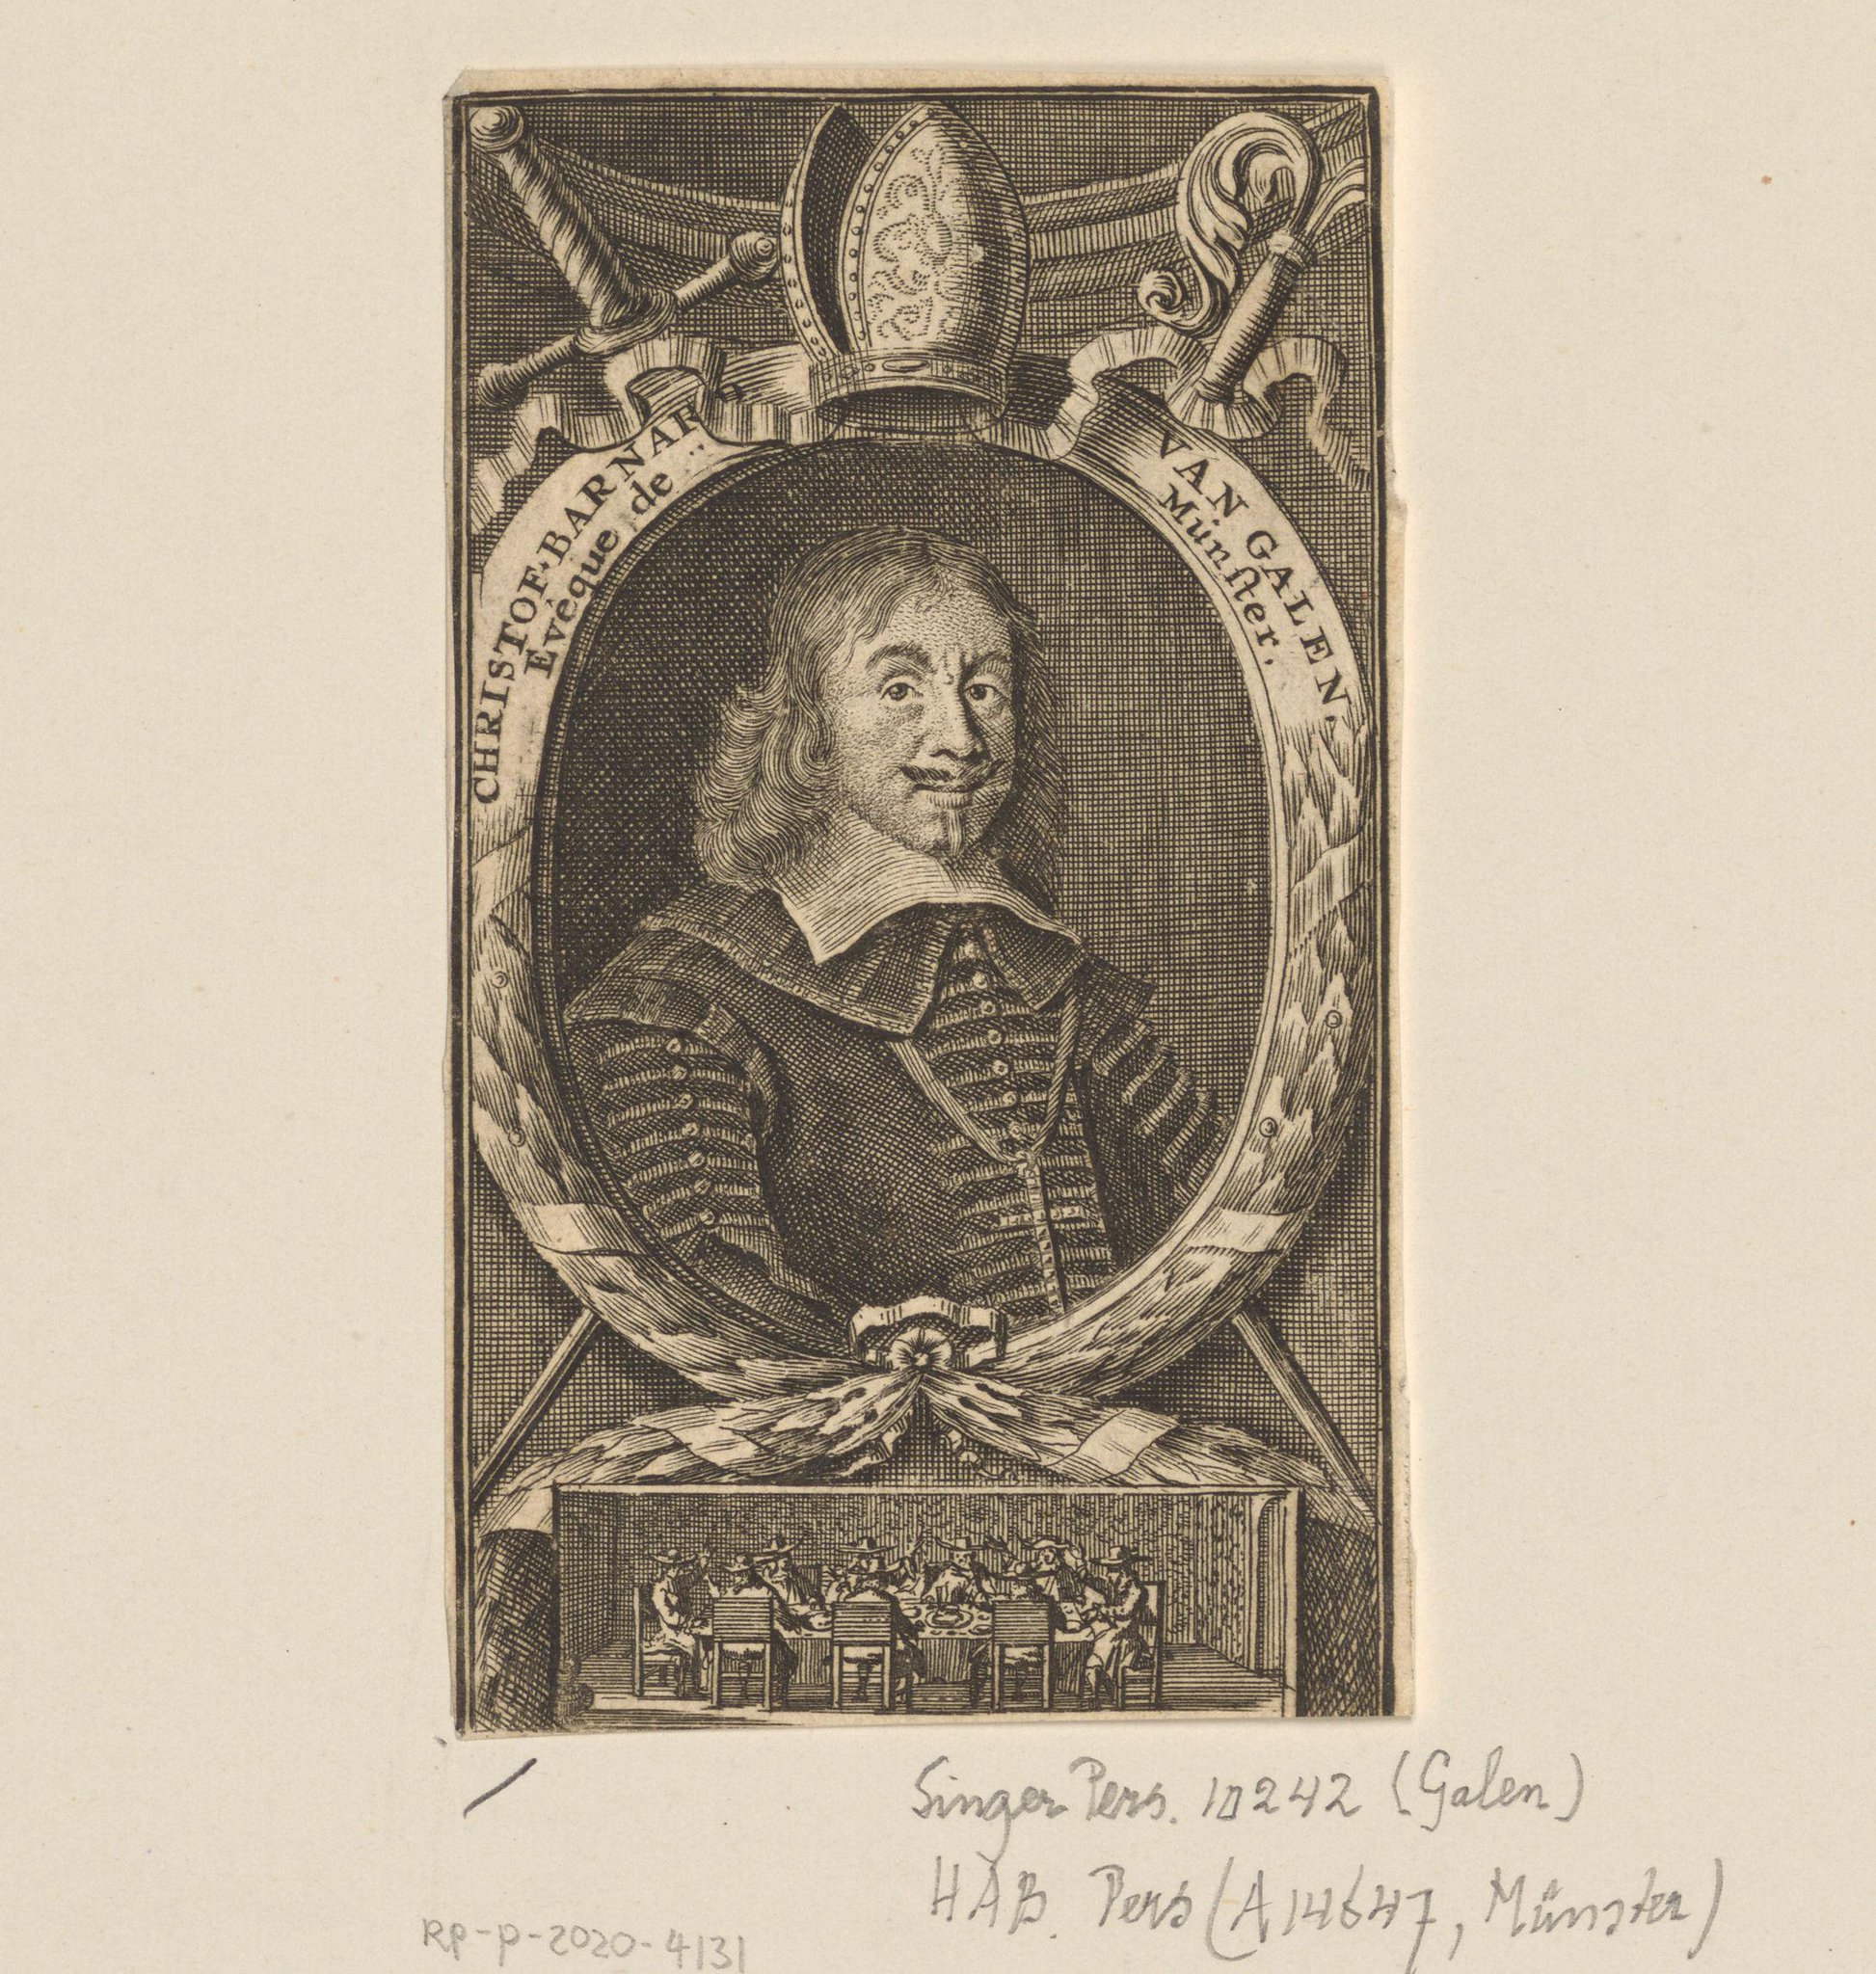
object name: print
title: Portret van Christoph Bernhard von Galen, bisschop van Münster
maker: françois cars (i)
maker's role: print maker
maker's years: 1631-1701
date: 1631-1701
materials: paper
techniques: engraving, etching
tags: theologian, historical persons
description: In de ondermarge negen mannen dinerend aan tafel.